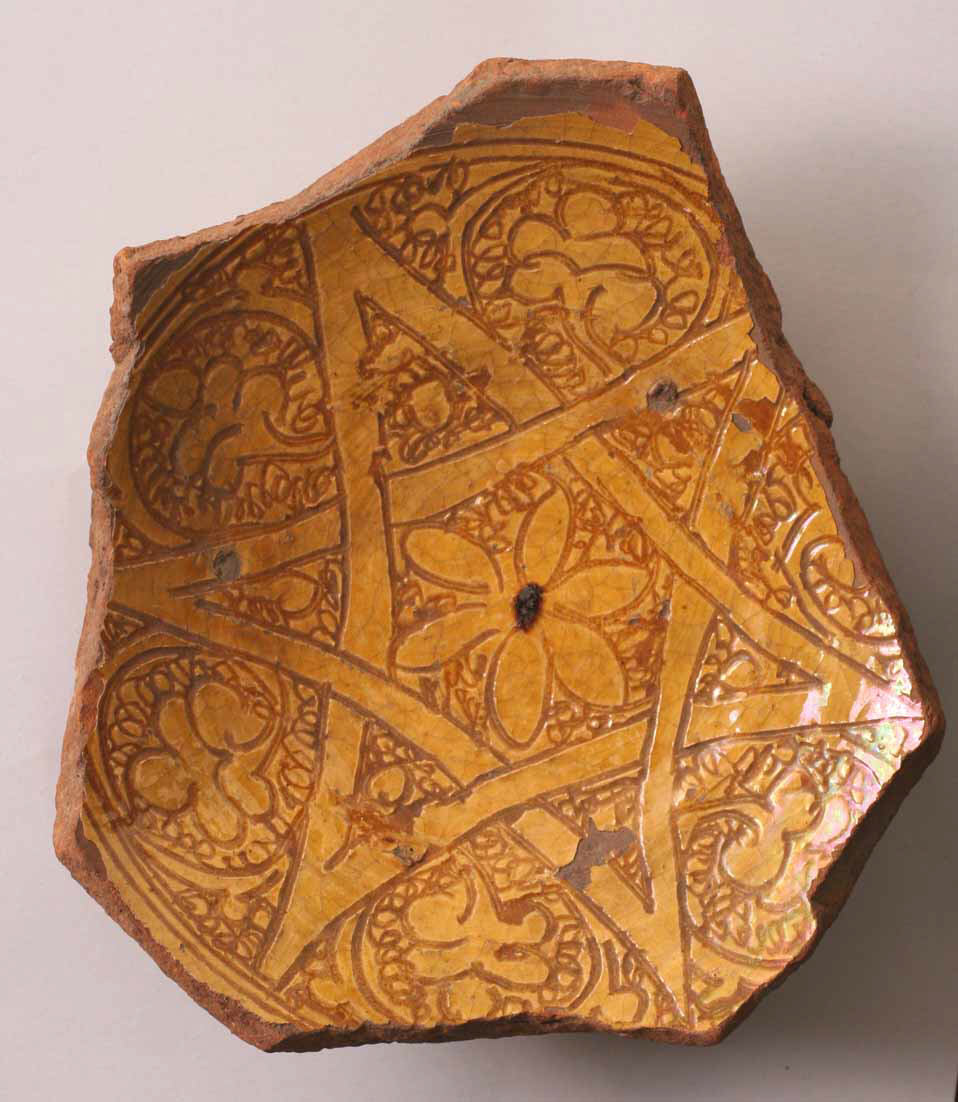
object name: ceramic fragment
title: Fragment of a Bowl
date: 1301-1500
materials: earthenware, glaze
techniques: coloring, incising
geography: egypt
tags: flowers